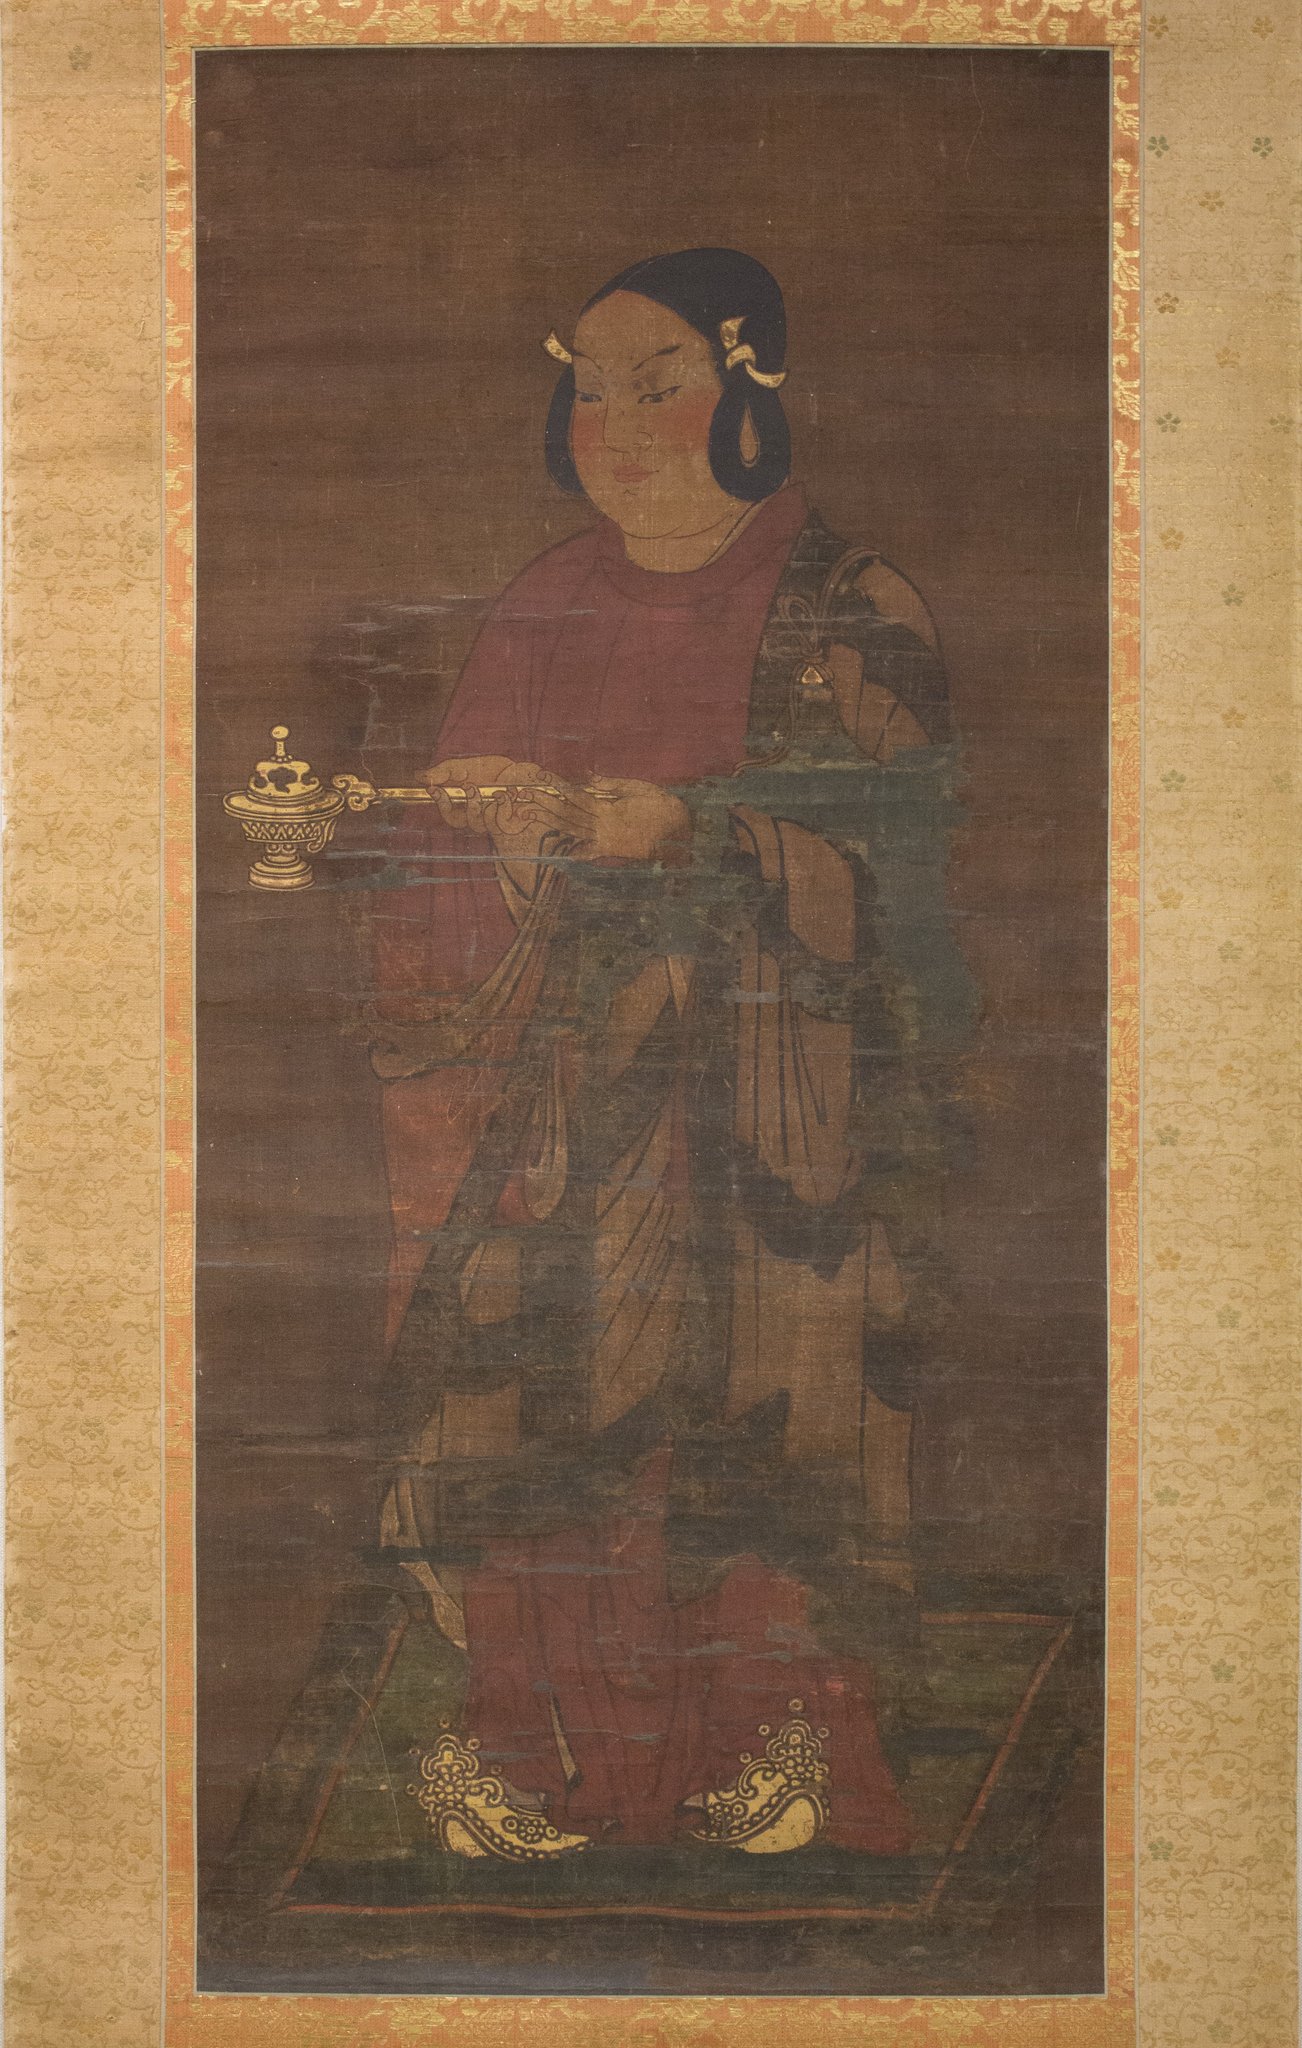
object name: hanging scroll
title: Prince Shōtoku at Age Sixteen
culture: japanese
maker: toba sōjō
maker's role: artist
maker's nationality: japanese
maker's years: 1053-1140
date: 1301-1400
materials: gold, ink, silk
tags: princes,men,censers